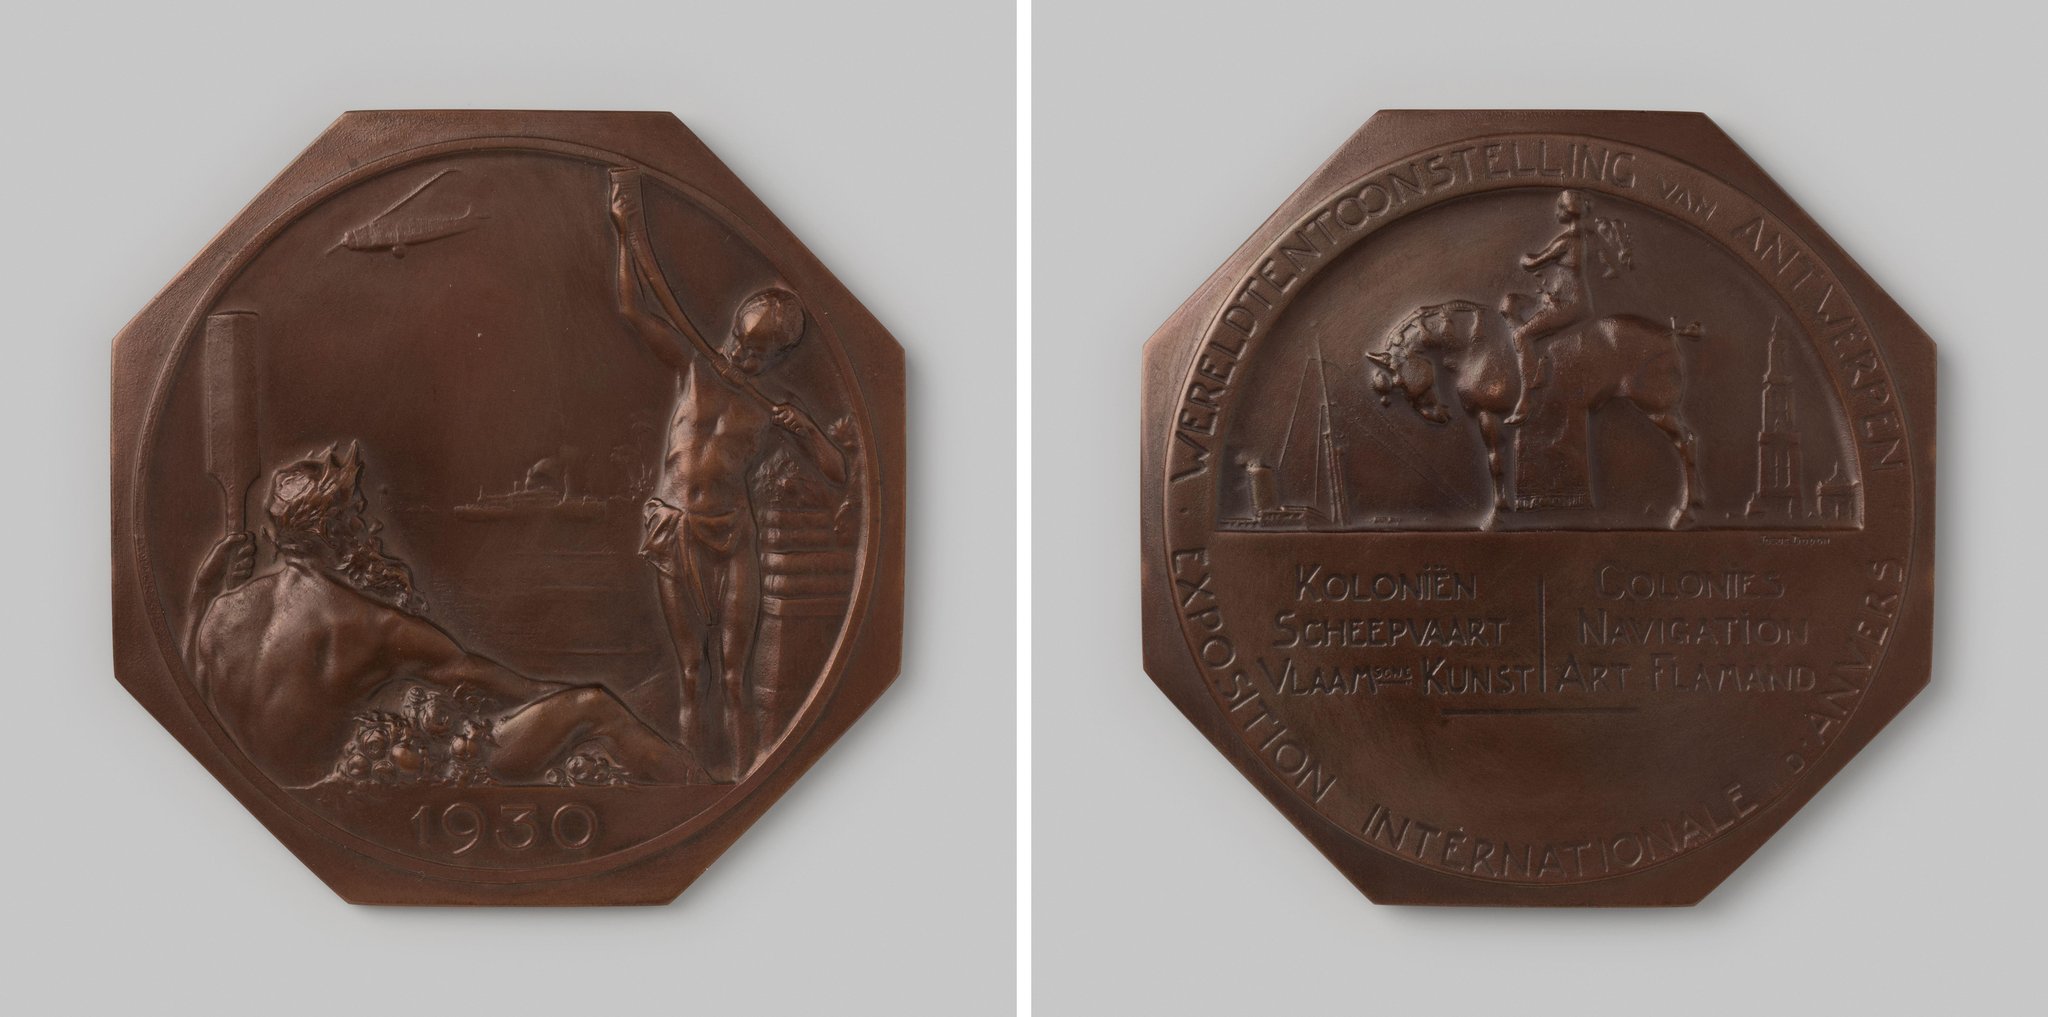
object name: history medal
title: Wereldtentoonstelling te Antwerpen 1930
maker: josué dupon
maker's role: print maker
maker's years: 1864-1935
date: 1930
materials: bronze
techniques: striking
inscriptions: : ‘J. FONSON’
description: Achthoekige bronzen plakette, op de voorzijde de zeegod bij een Congolees met blaasinstrument, op de achtergrond een rivier, schip en vliegtuig, op de keerzijde een scheepsmast, vrouw te paard en kerktoren boven drie regels tekst, met omschrift.